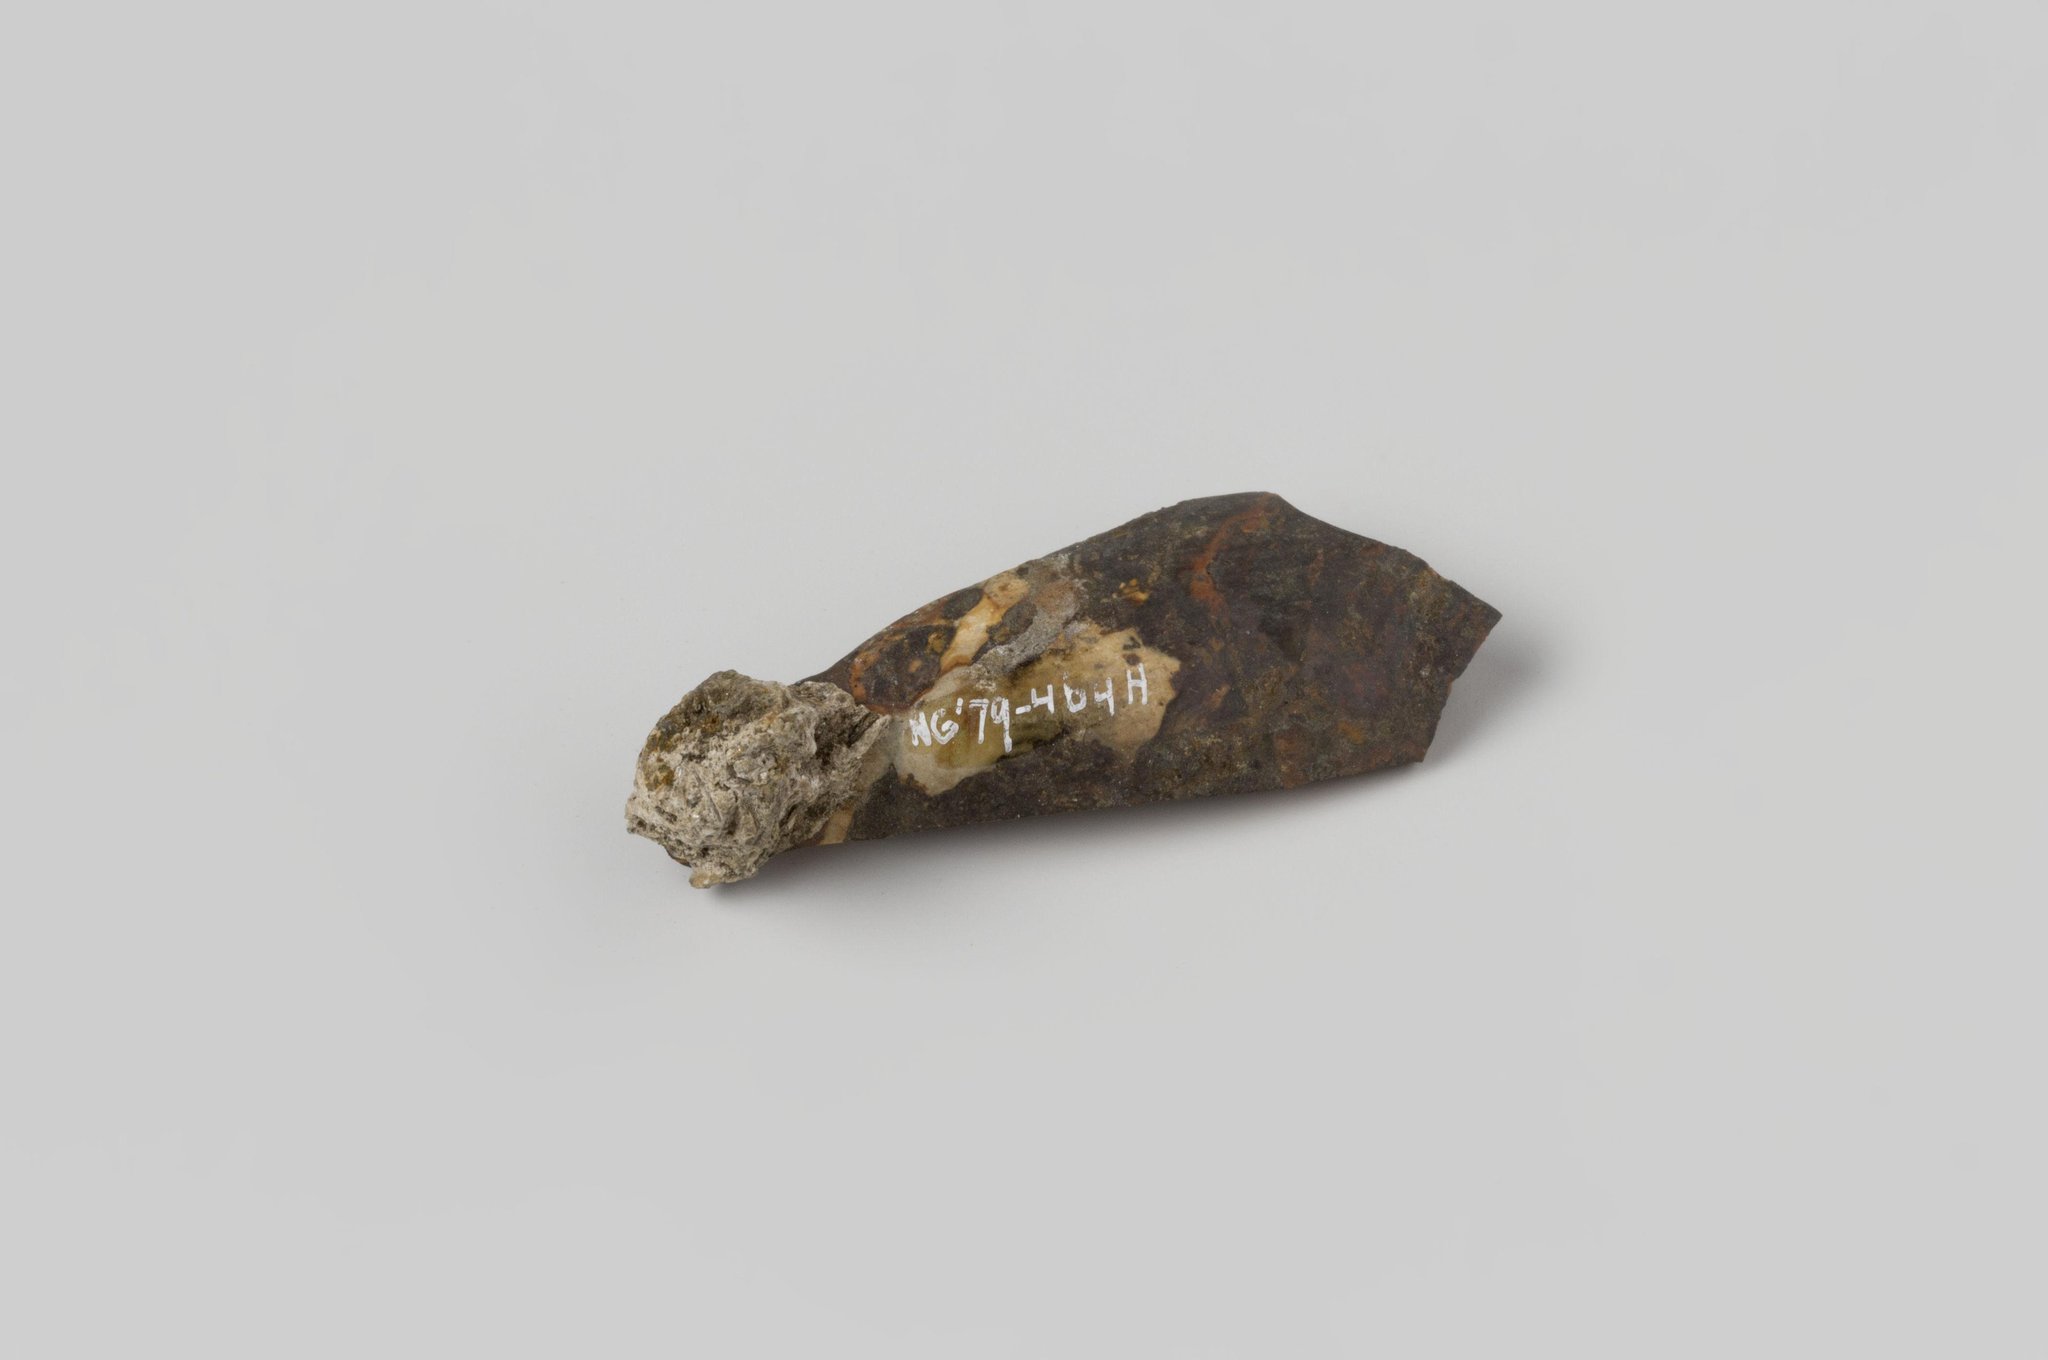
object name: pipe bowl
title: Fragment pijpenkop uit het wrak van de Oost-Indiëvaarder Hollandia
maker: Anonymous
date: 1700-1743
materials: clay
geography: netherlands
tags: verenigde oostindische compagnie, hollandia (schip), annet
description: Pipe, bowl, heelmark illegible; fragment.